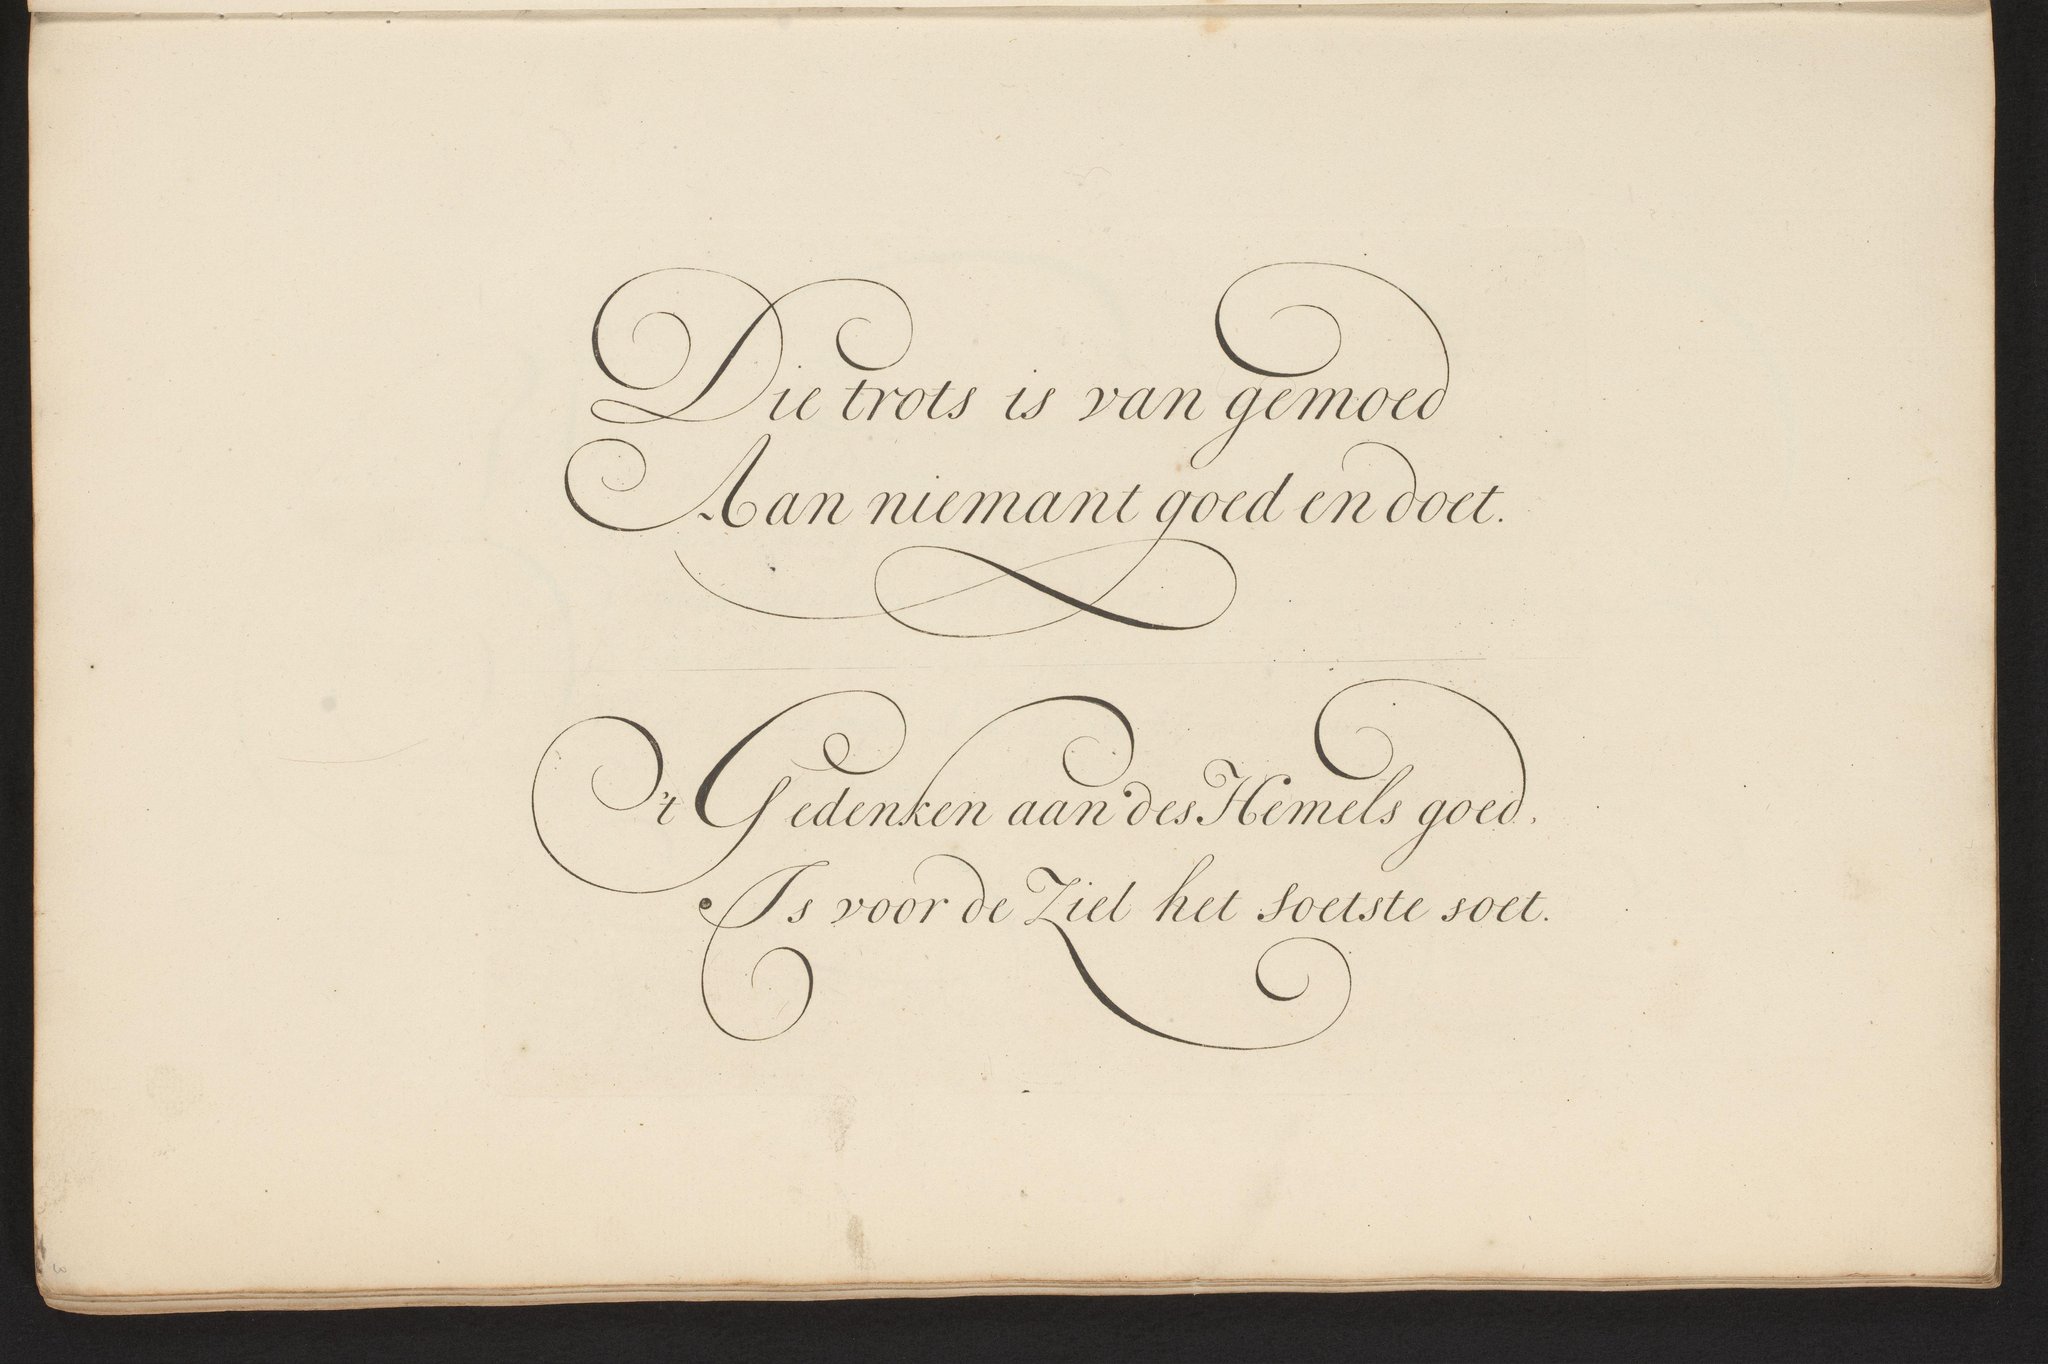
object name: print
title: Schrijfvoorbeeld: Die trots is van gemoed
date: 1660-1751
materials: paper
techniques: engraving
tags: calligraphy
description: Schrijfvoorbeeld met twee keer twee regels tekst in het Nederlands: Die trots is van gemoed ... De prent maakt deel uit van een album